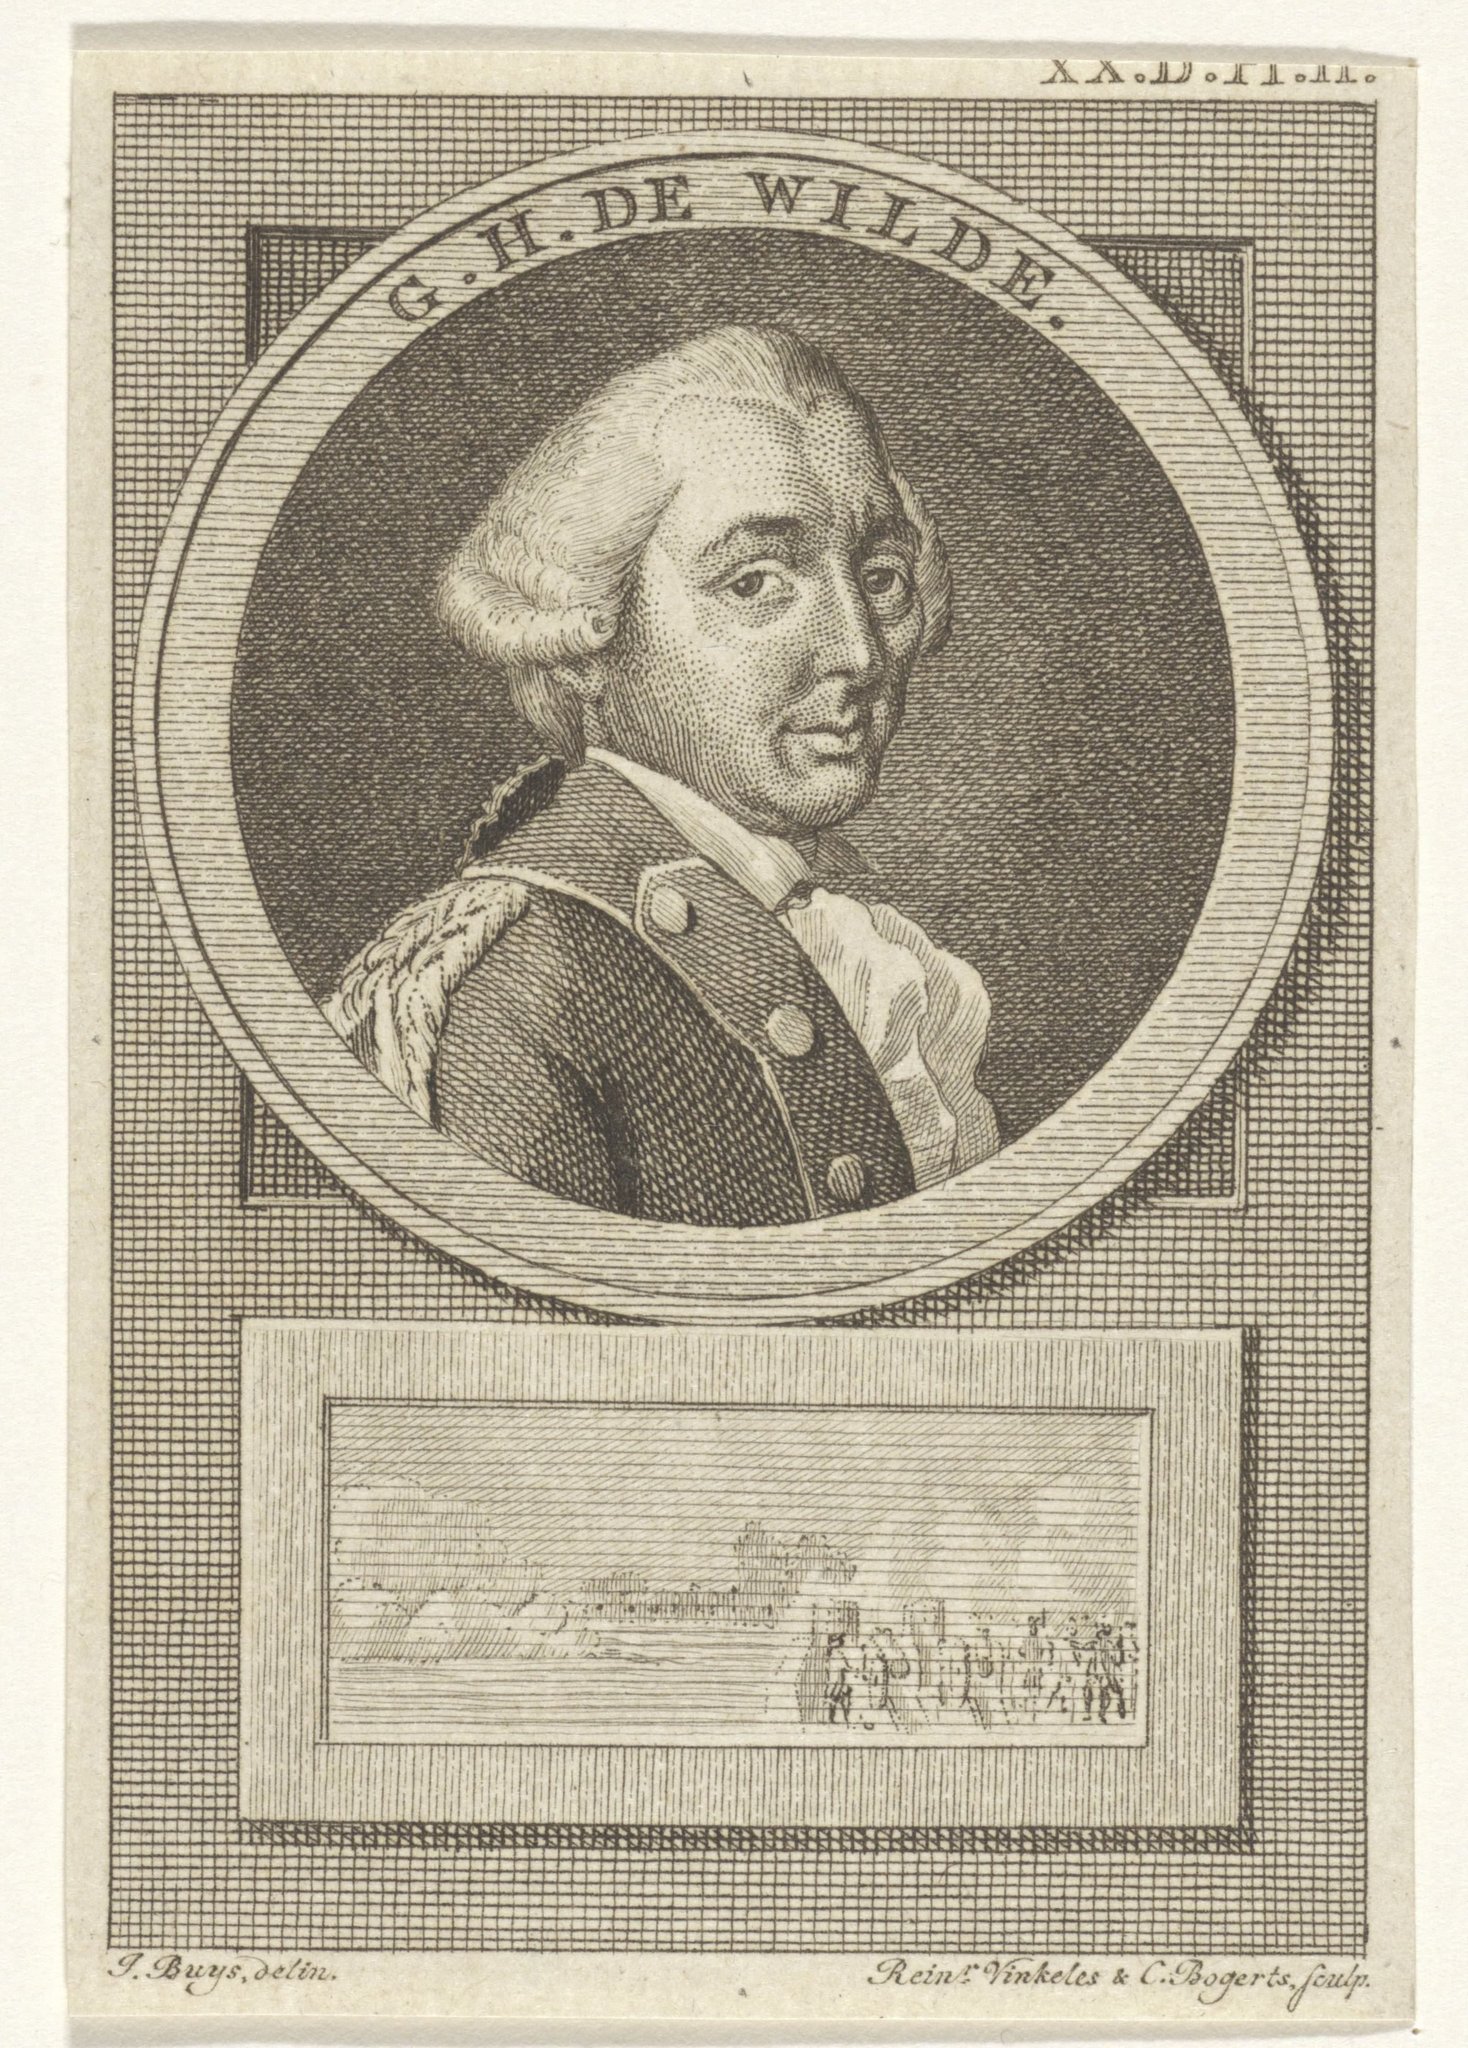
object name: print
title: Portret van George Hendrik de Wilde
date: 1783-1795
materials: paper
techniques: engraving, etching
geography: amsterdam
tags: luitenant-kolonel, george hendrik de wilde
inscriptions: collector's mark: Lugt 2228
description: Prent gebruikt in: Fokke, Jan. Geschiedenissen der Vereenigde Nederlanden voor de vaderlandsche jeugd Ie-XXVste deel. Amsterdam: Johannes Allart, 1783-1795. Deel XX.